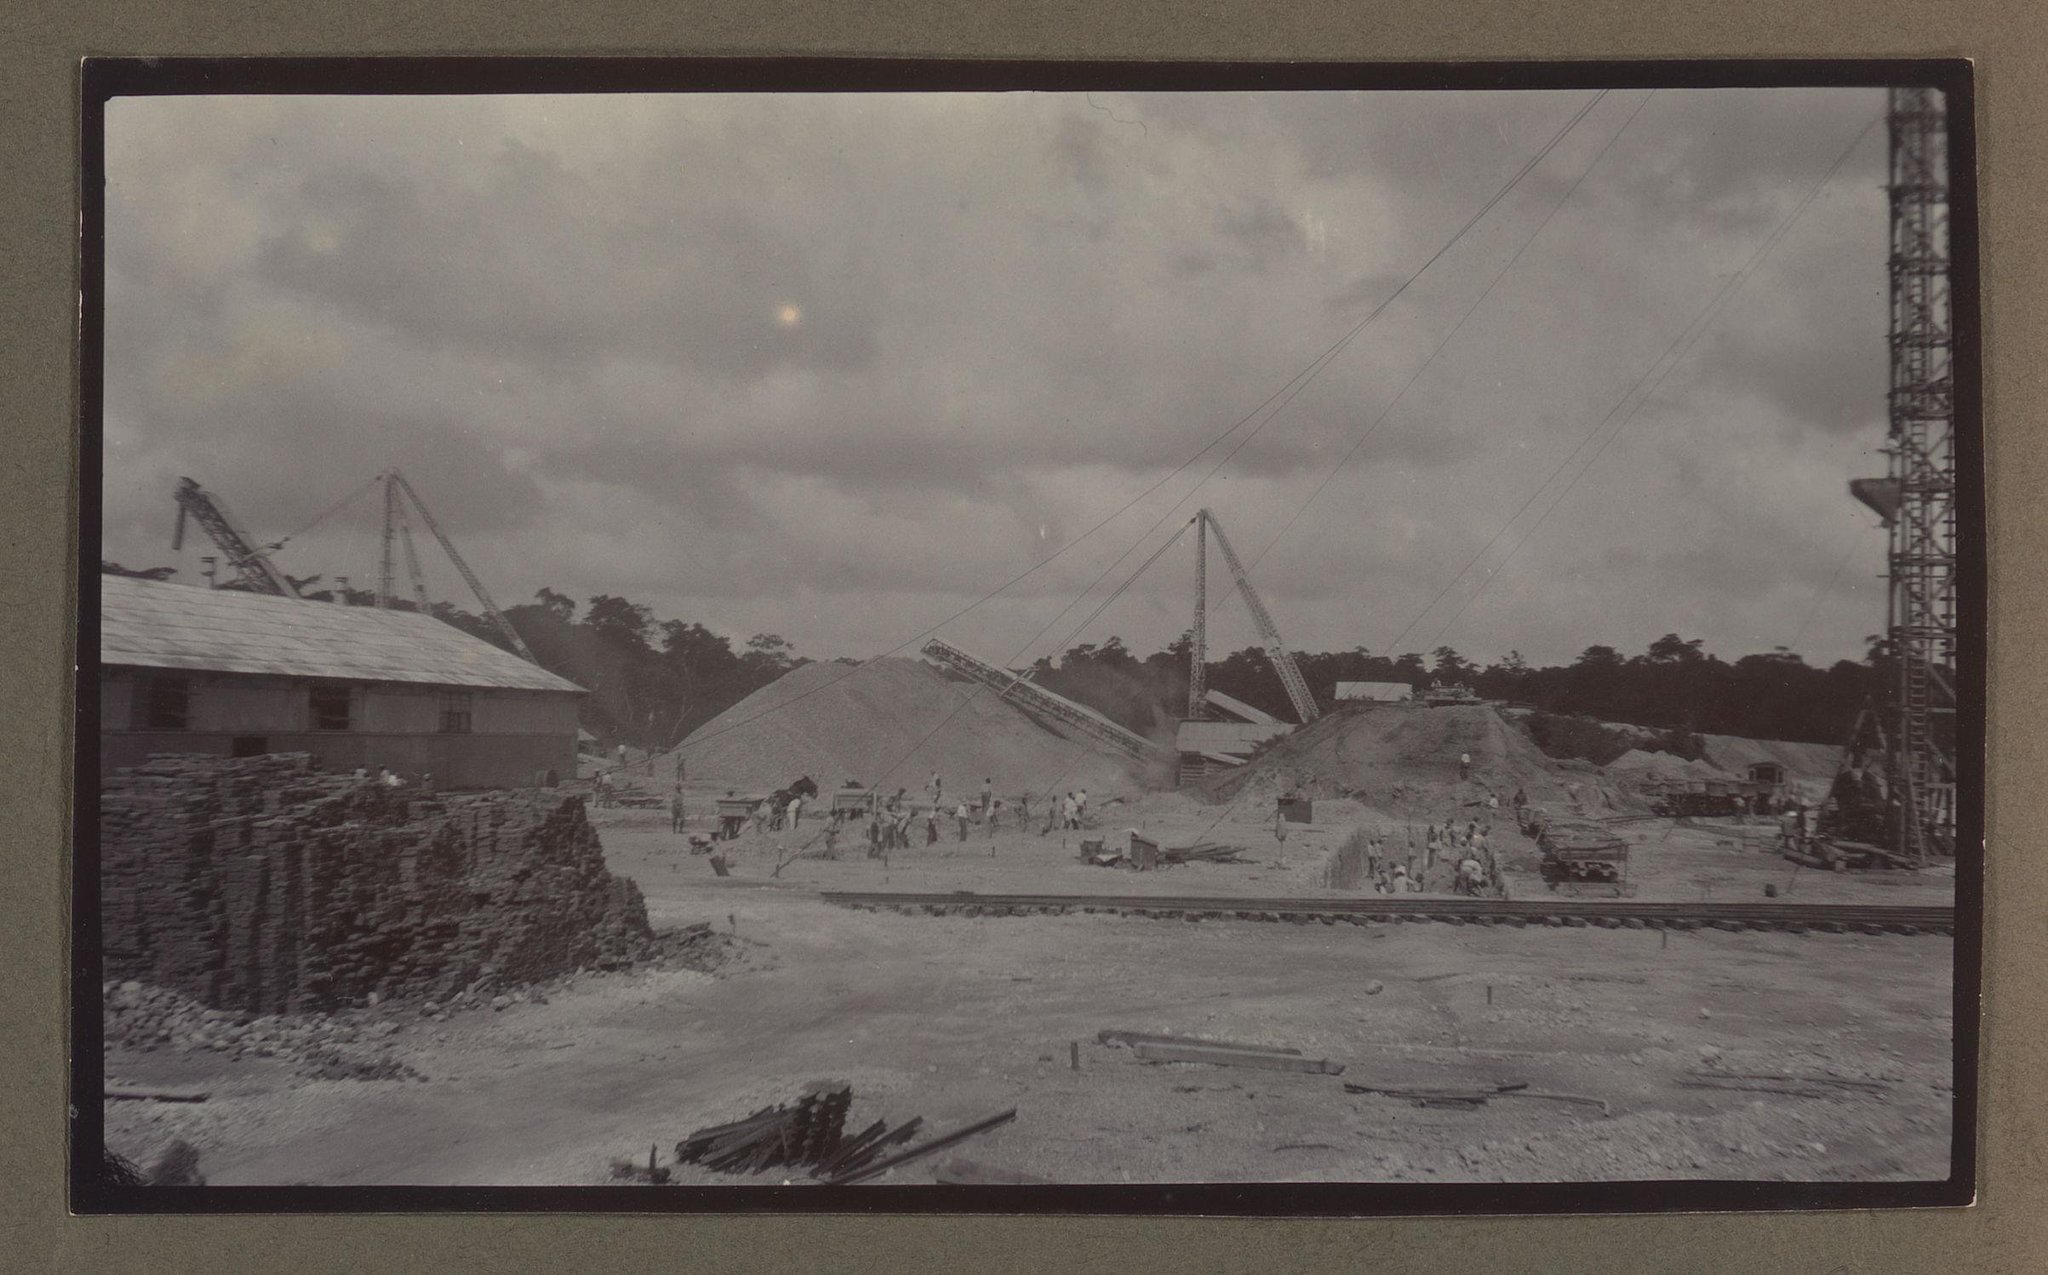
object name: photograph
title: Mijn en fabriek in Moengo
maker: Anonymous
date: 1925-1927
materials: photographic support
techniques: photography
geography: suriname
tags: jetten, familie, moengo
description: Terrein van de mijn en fabriek in Moengo. Foto op een bladzijde van een los albumblad. Onderdeel van het ensemble met foto's van de familie van ingenieur Jetten in de mijnbouwstad Moengo in Suriname.